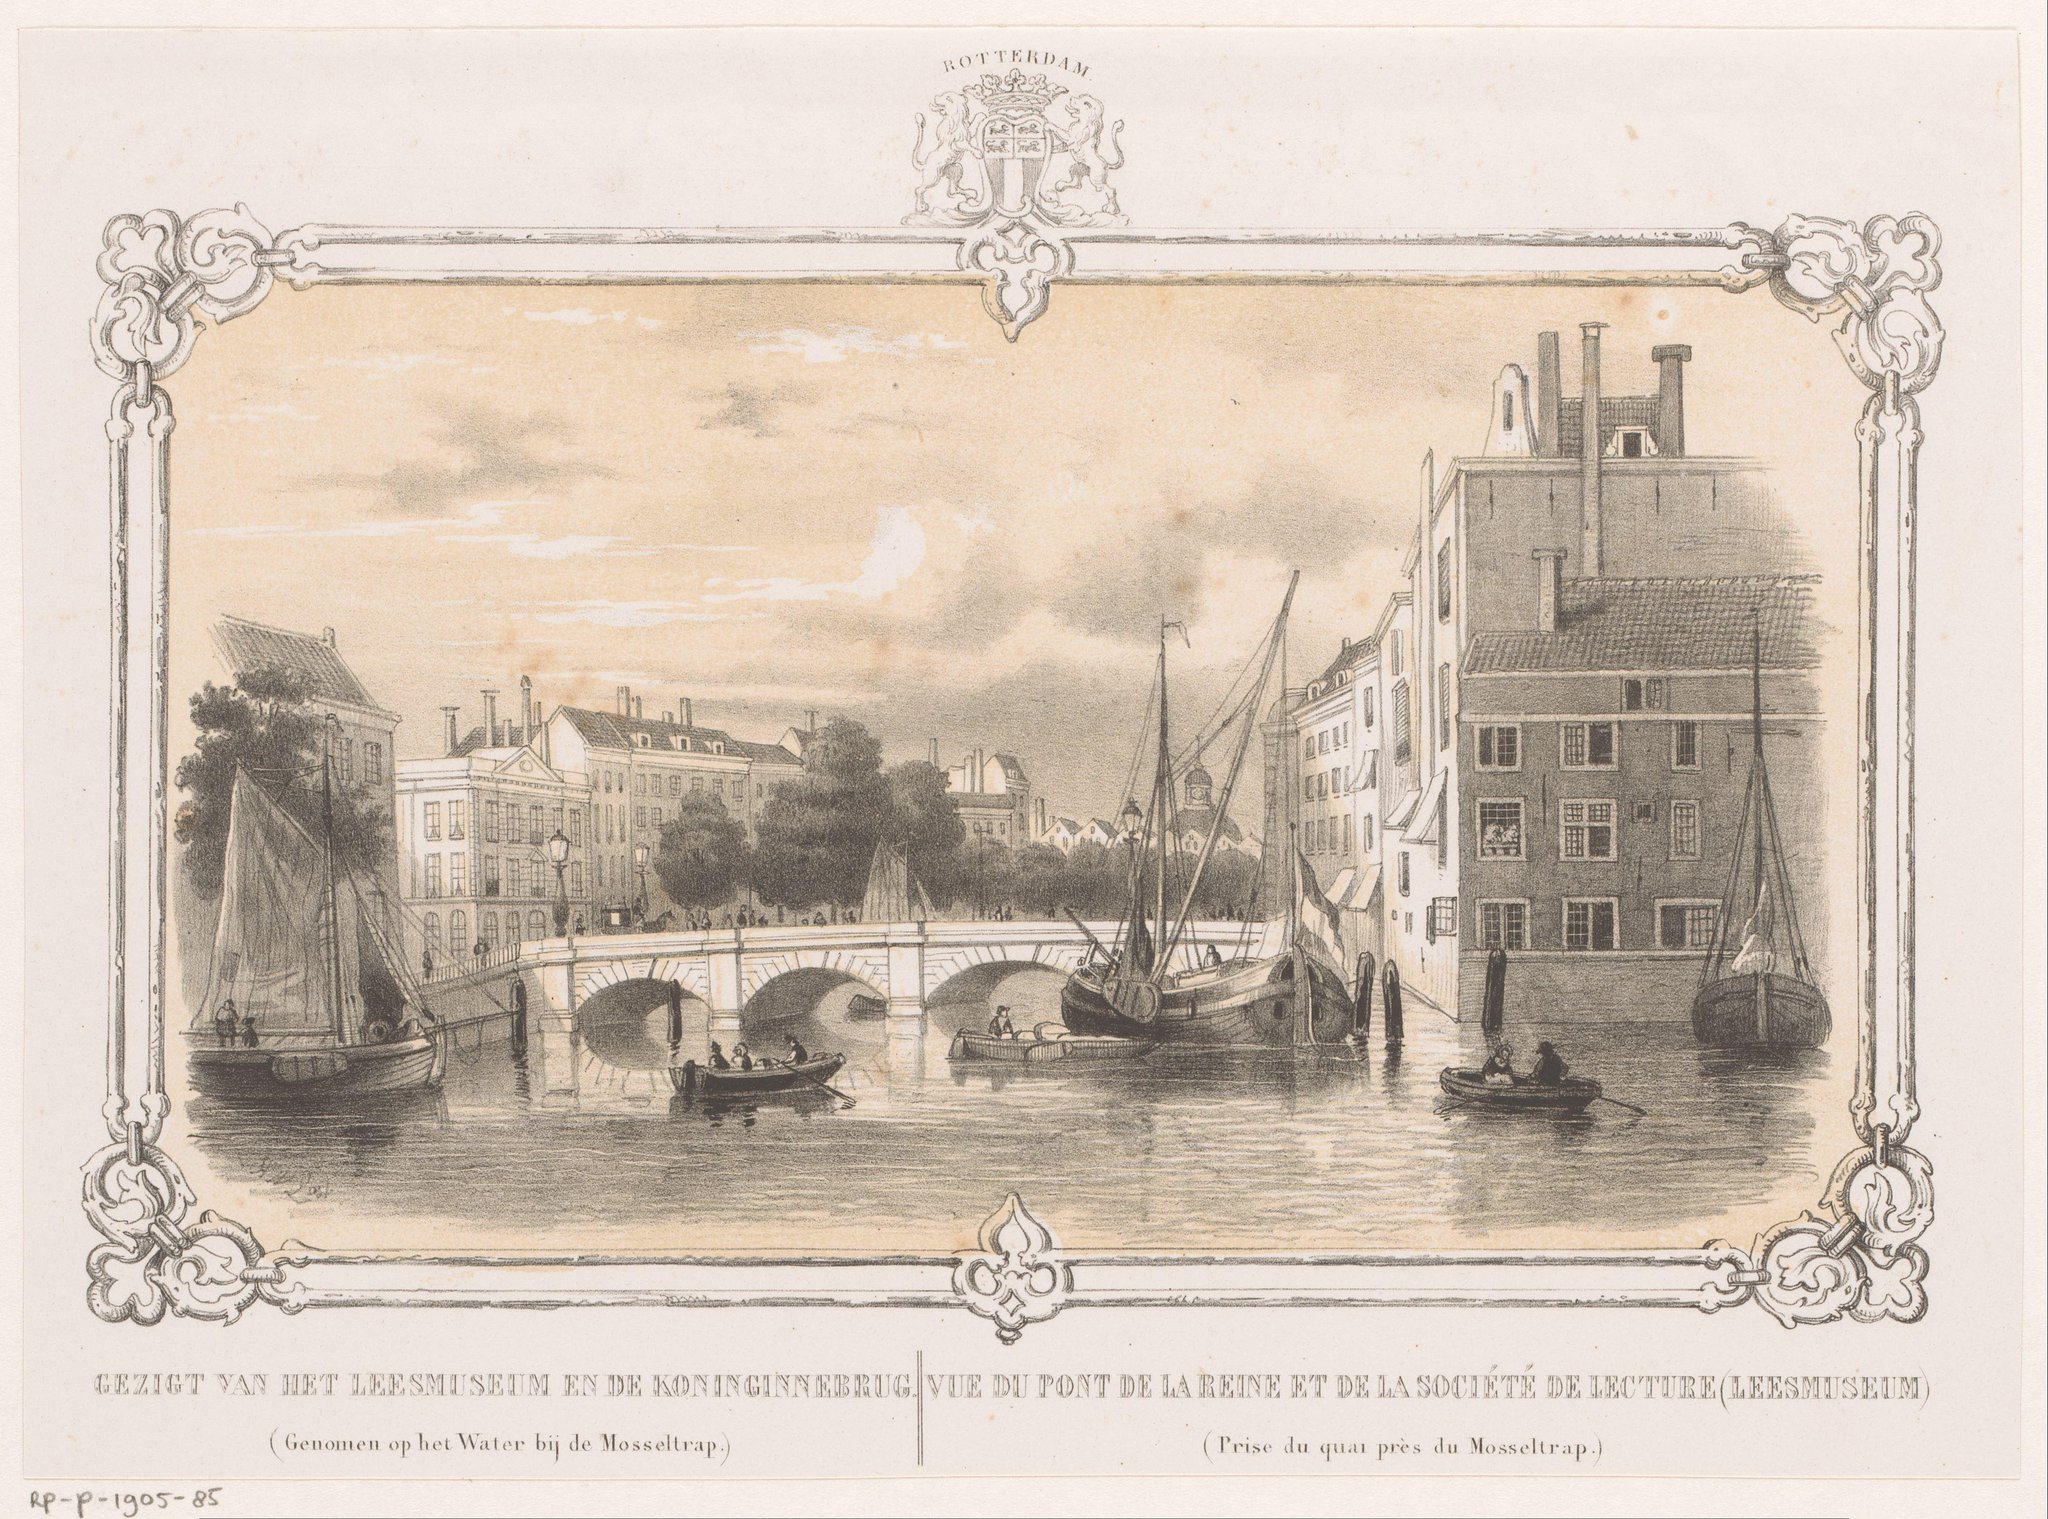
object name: print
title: Gezicht op Rotterdam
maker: hendrik wilhelmus last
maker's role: print maker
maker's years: 1817-1873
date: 1827-1873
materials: paper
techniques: tone lithography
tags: bridge in city across river, canal, etc. (+ city(-scape) with figures, staffage), rotterdam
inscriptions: collector's mark: Lugt 2228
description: Gezicht op de Beursbrug, later Koninginnebrug, vanaf de Mosseltrap. Links achter de brug de sociëteit Het Leesmuseum, in de achtergrond de koepel van de Lutherse Kerk.